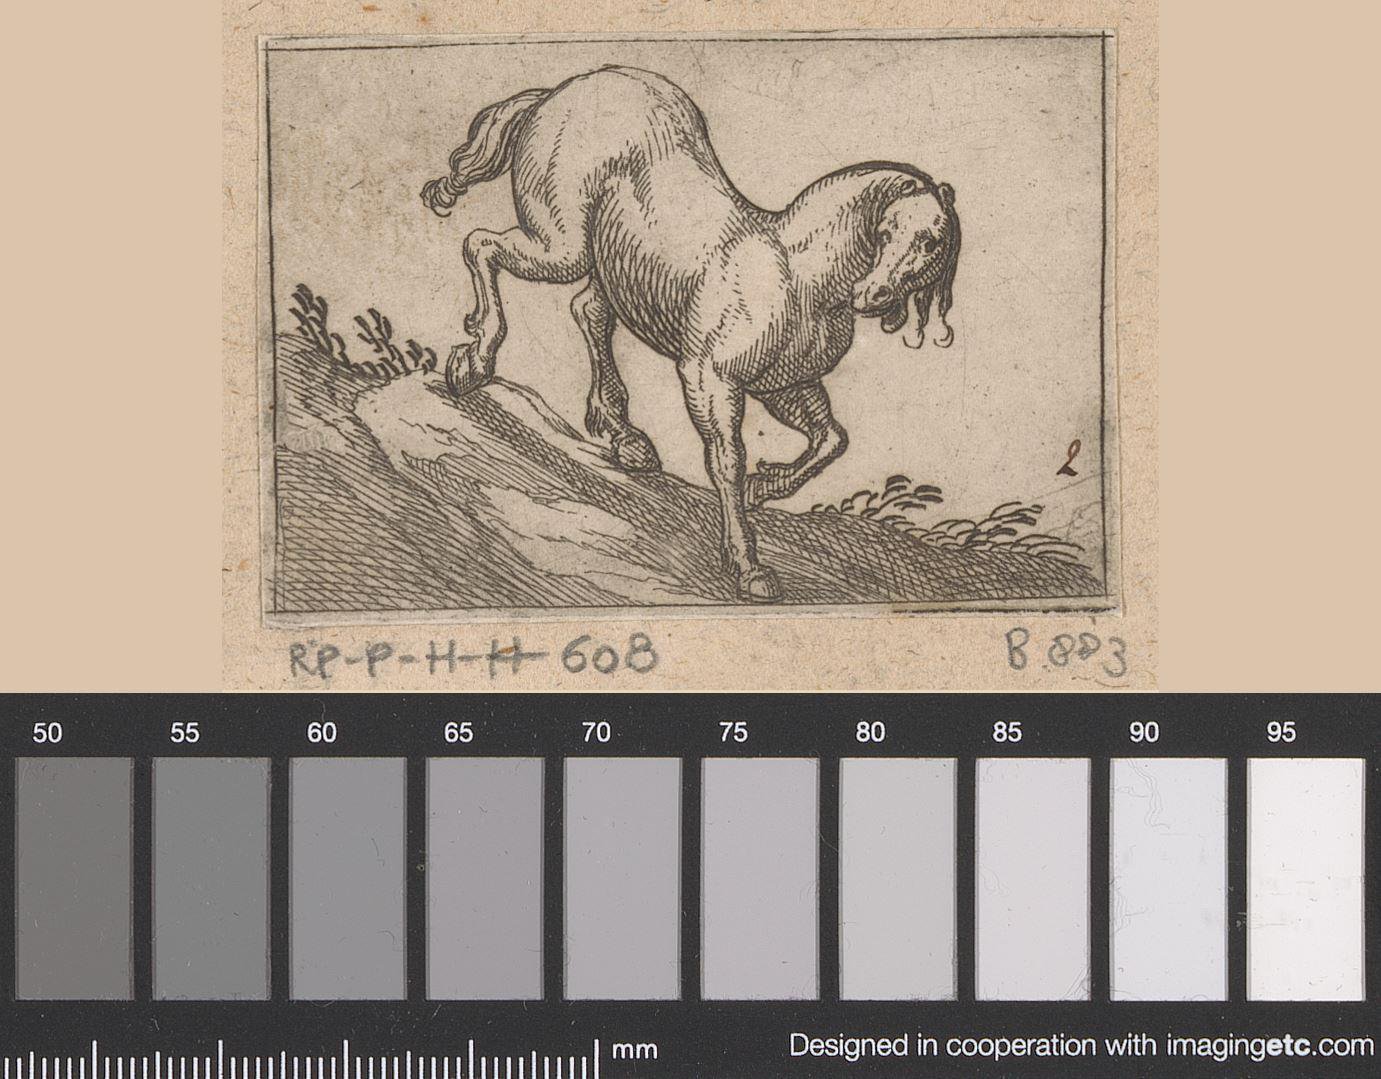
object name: print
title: Paarden in verschillende houdingen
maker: antonio tempesta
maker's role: draughtsman, painter, print maker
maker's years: 1555-1630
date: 1565-1630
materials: paper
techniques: etching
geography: italy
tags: horse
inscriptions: number: ‘2’, collector's mark: Lugt 11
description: Deze prent maakt deel uit van een reeks van 24 prenten van paarden.